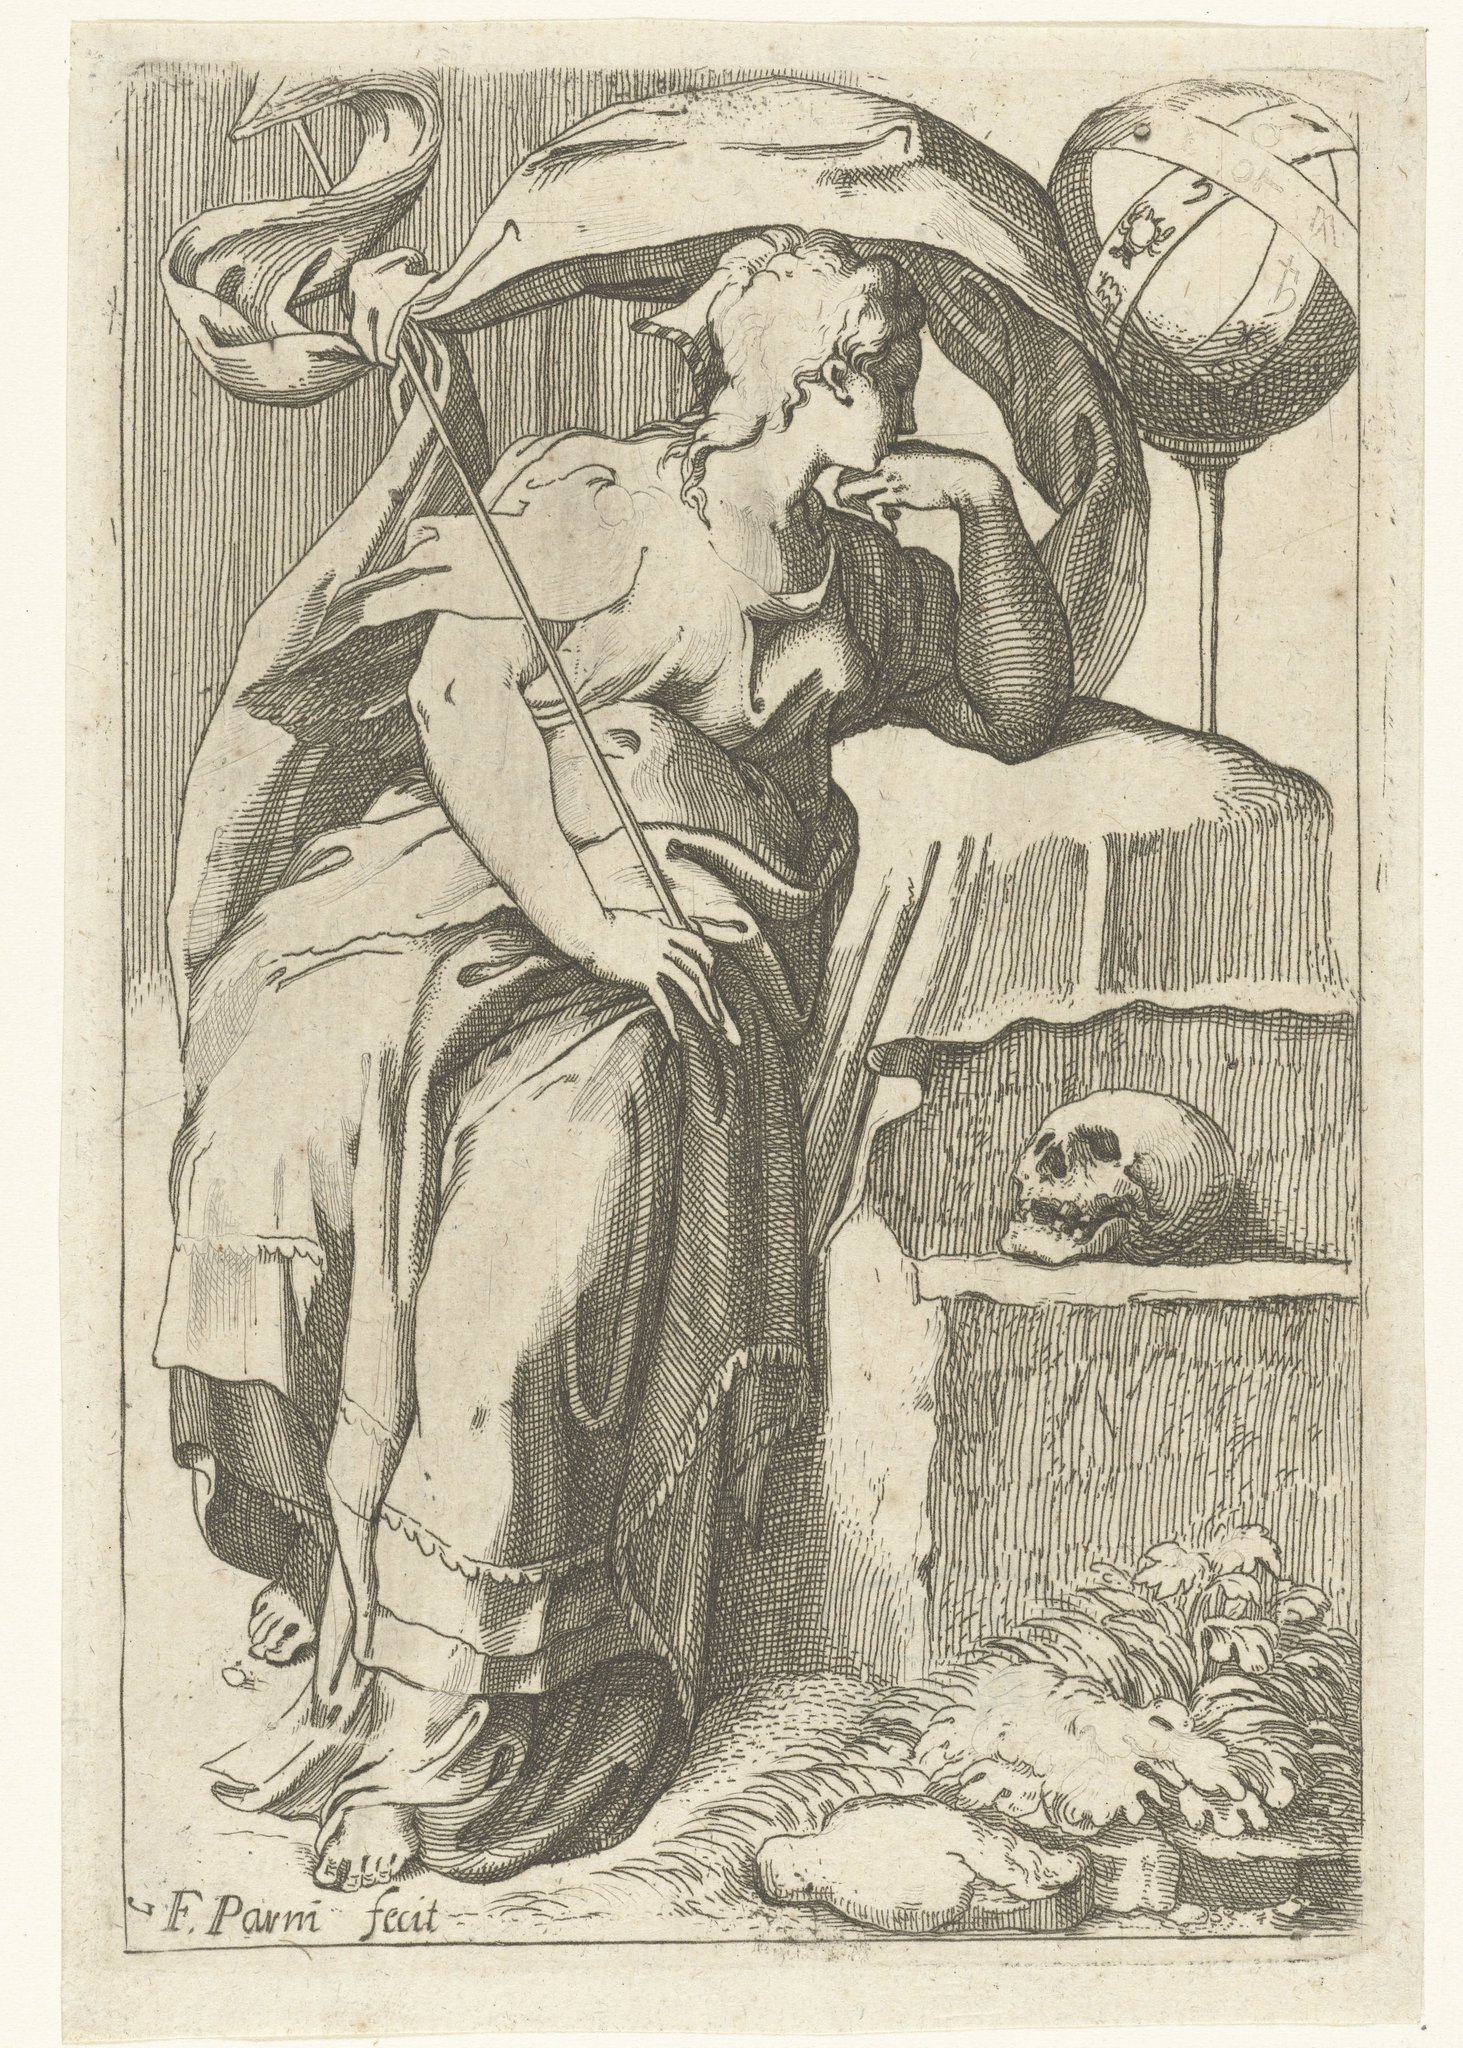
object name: print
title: Astrologie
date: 1520-1590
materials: paper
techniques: drypoint, etching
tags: 'astrologia' (ripa)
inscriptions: collector's mark: Lugt 2228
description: Personificatie van de Astrologie. Een vrouw, zittend op een rotsblok en in haar hand een staf met een doek er omheen geknoopt. Naast haar een bol met de sterrenbeelden en een schedel. Een kopie in spiegelbeeld.